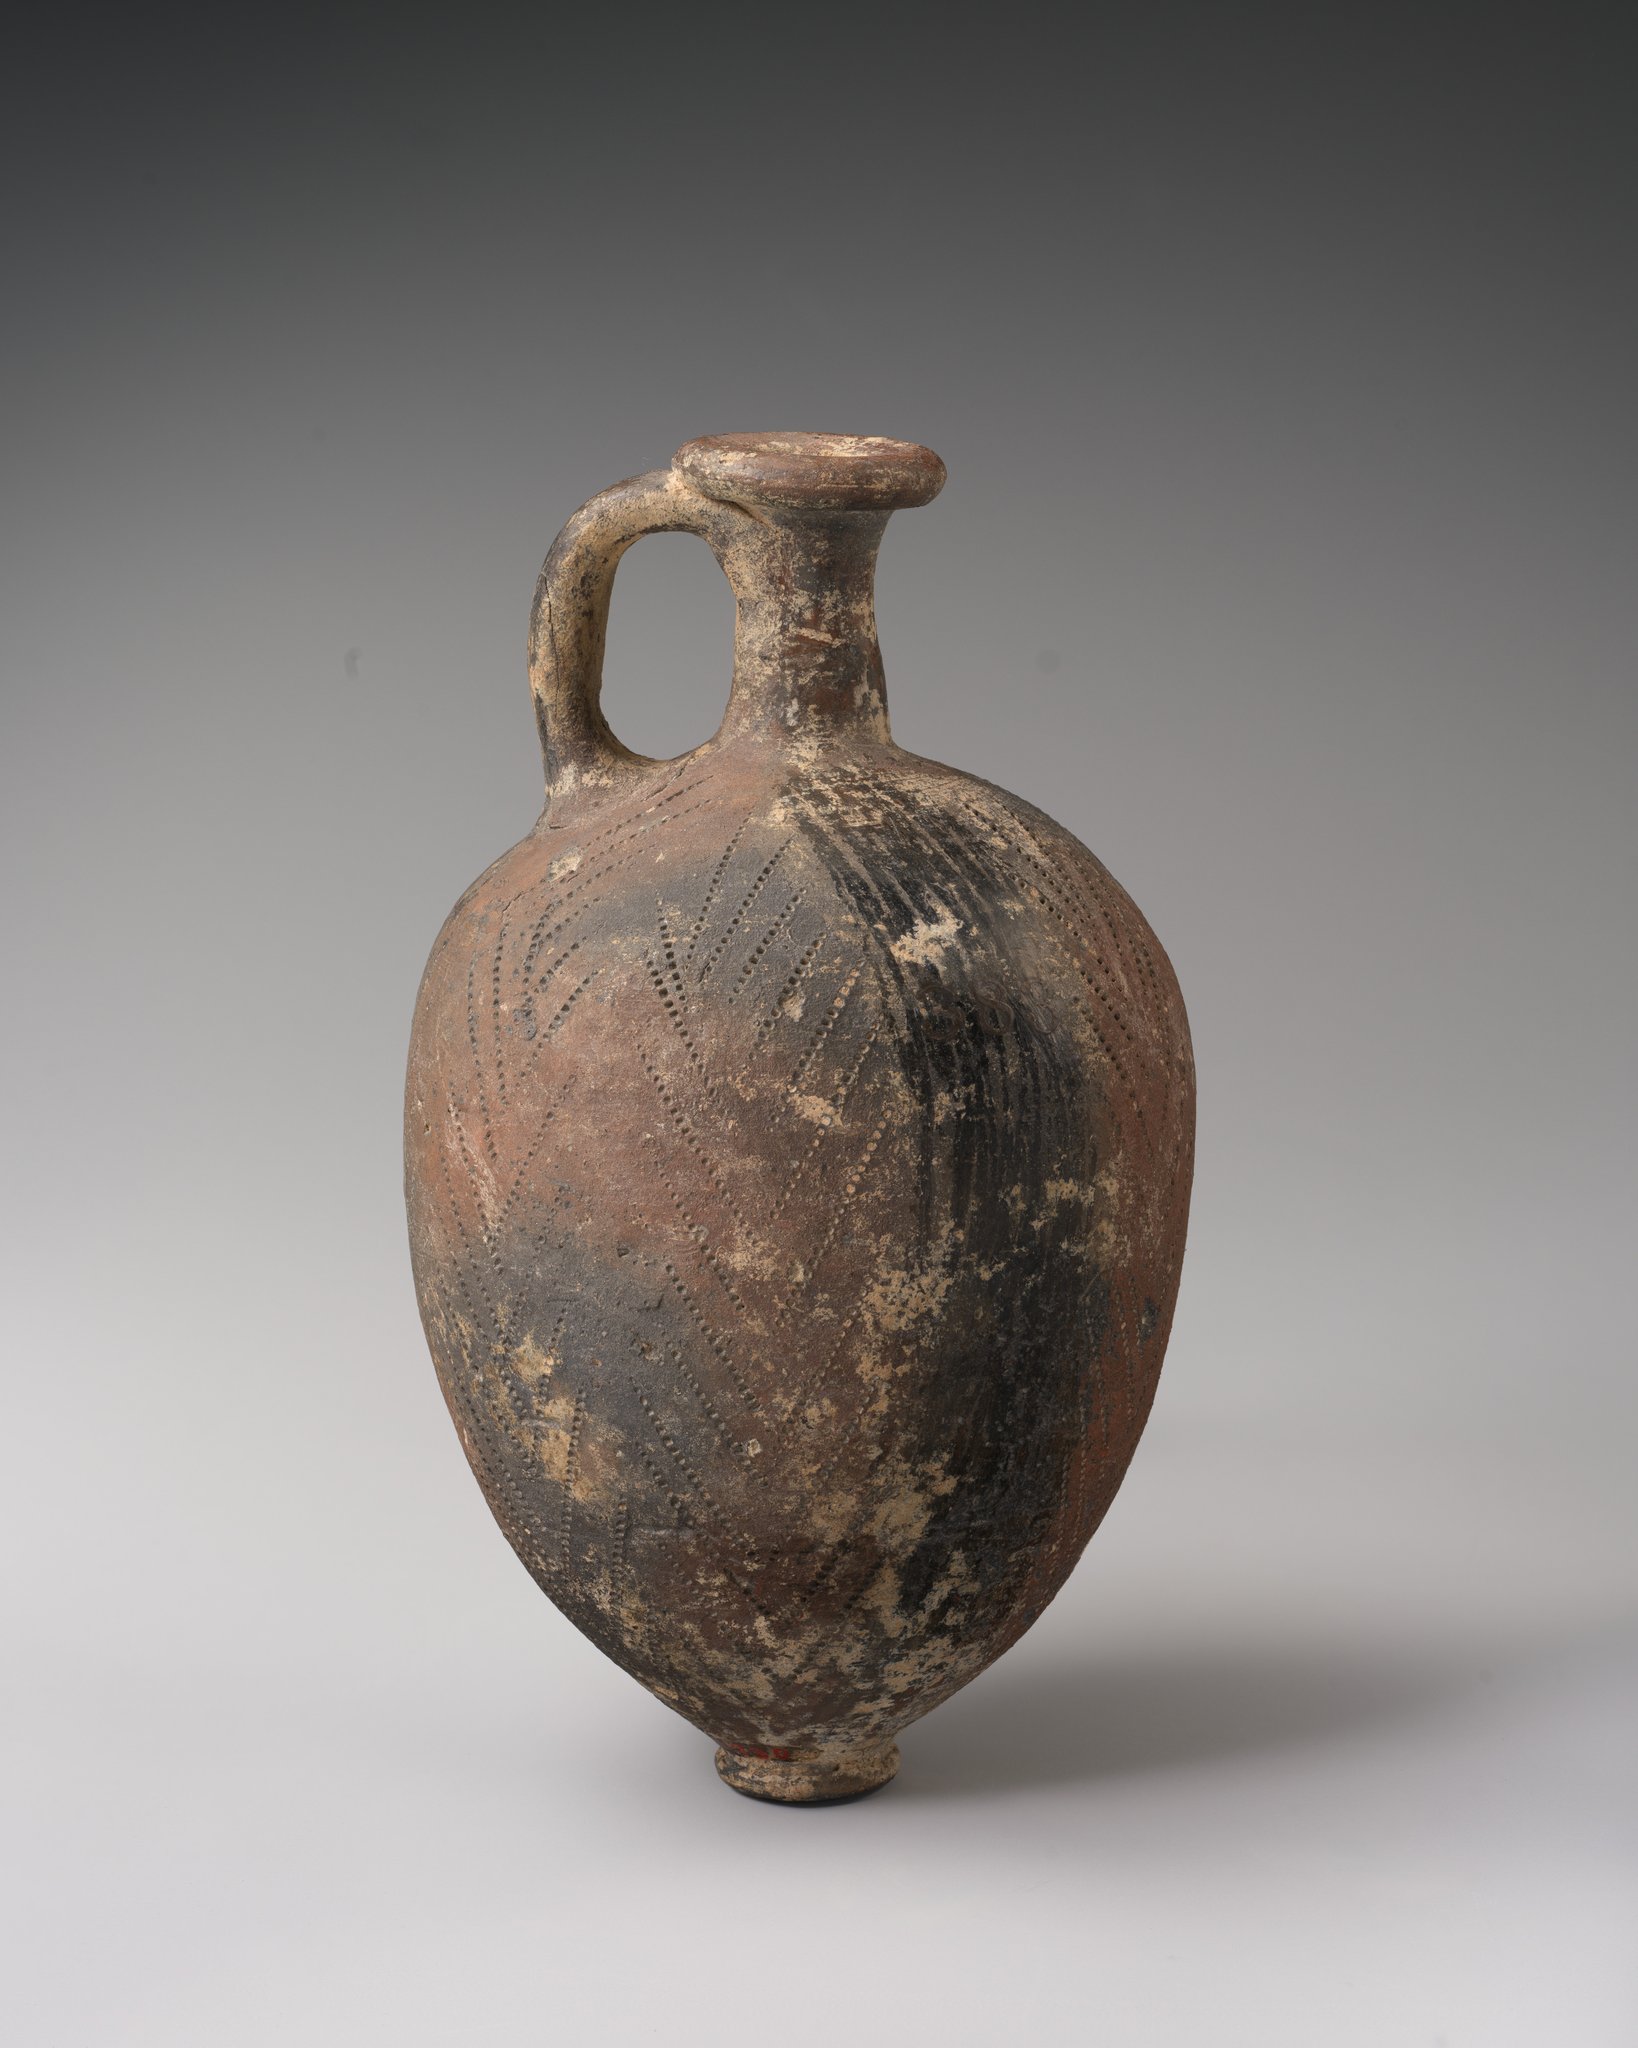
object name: juglet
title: Terracotta vessel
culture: egyptian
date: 1600 BCE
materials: terracotta